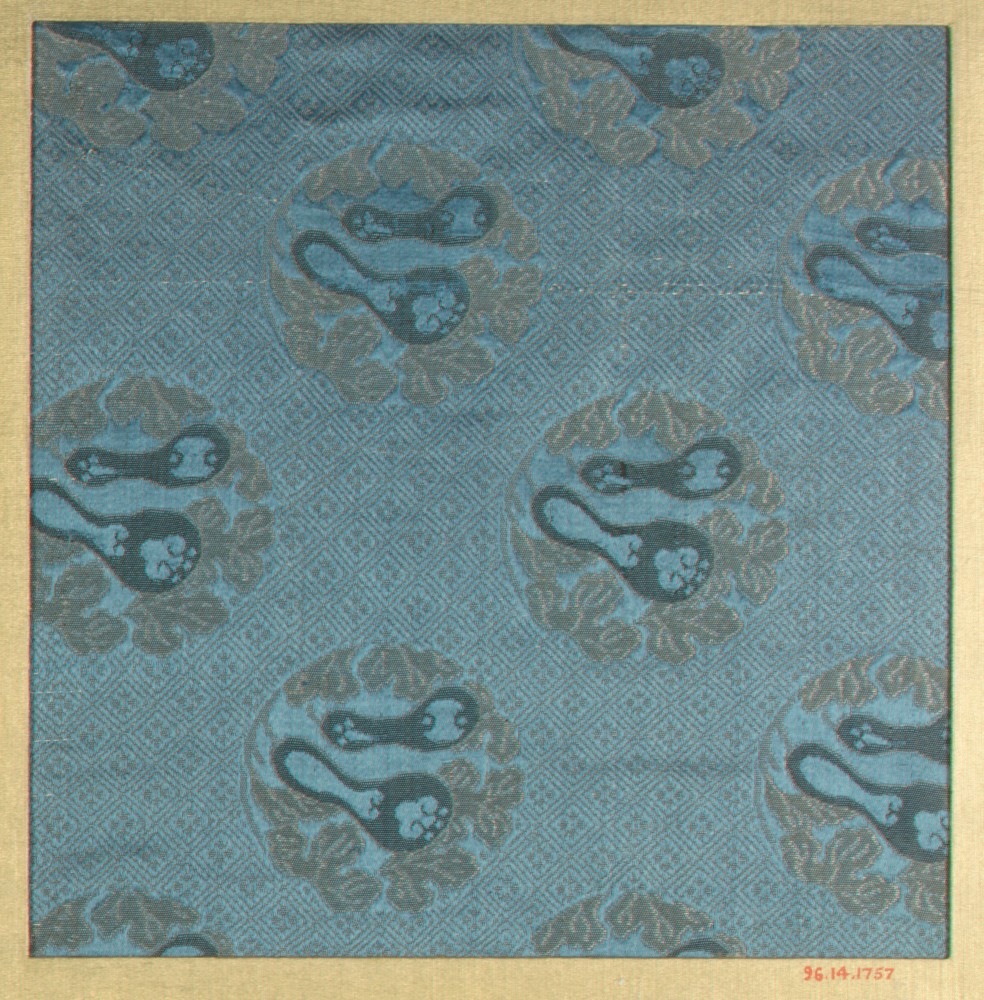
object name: piece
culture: japanese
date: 1701-1900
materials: silk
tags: gourds